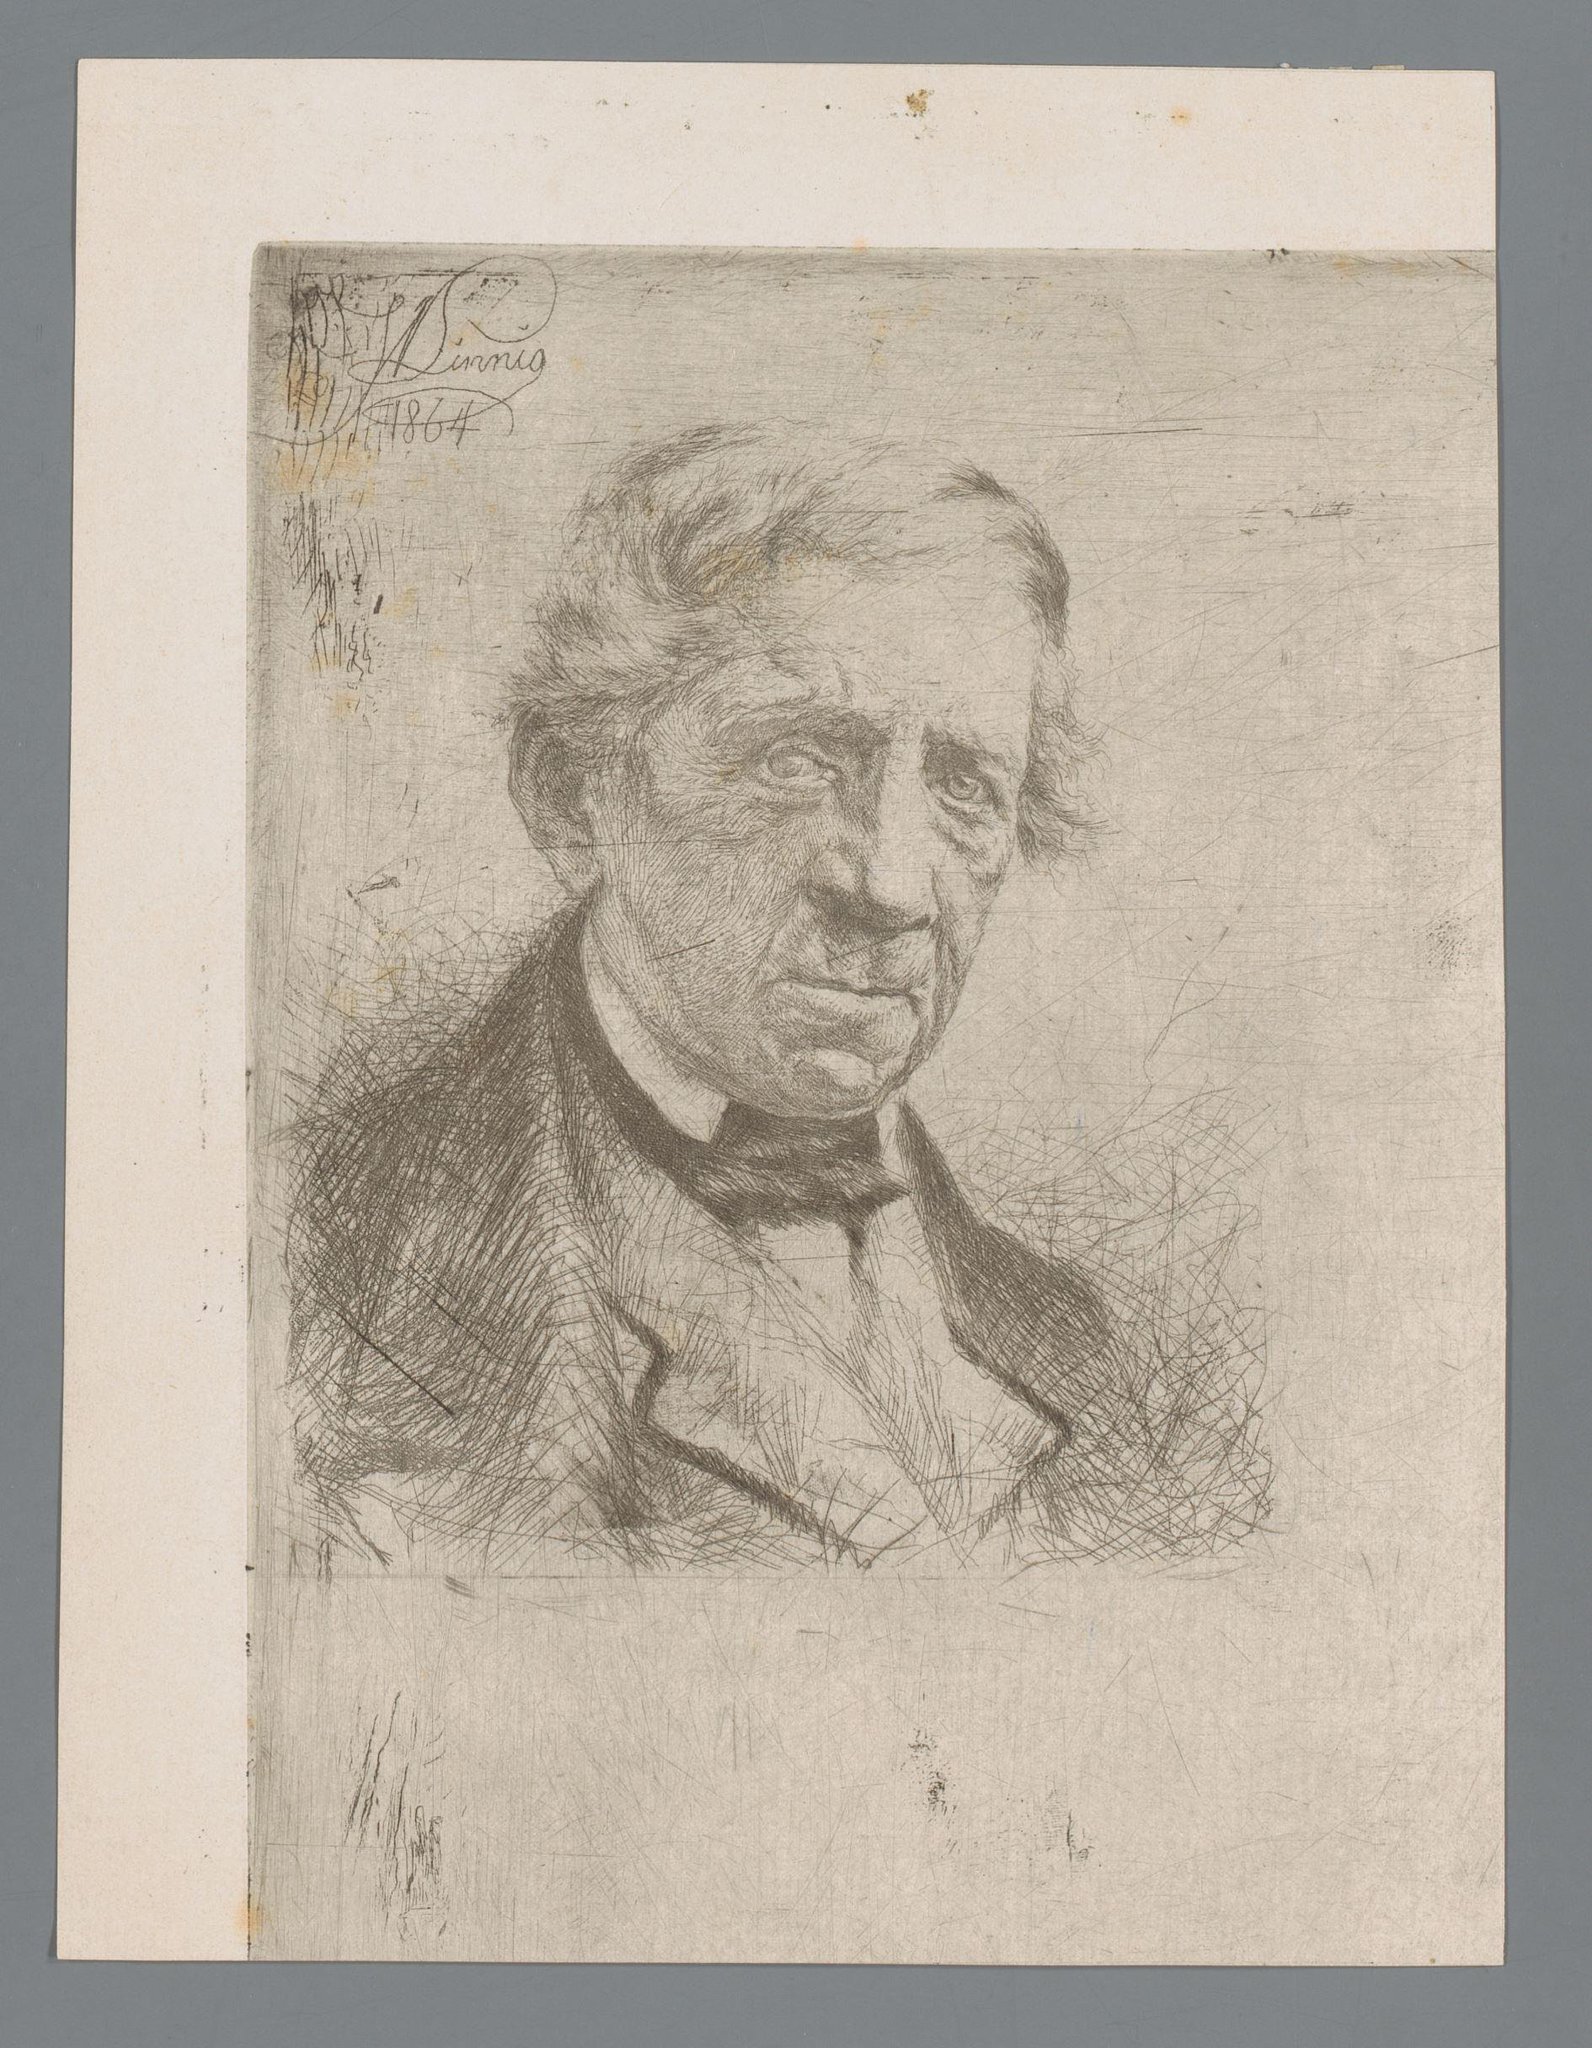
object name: print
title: Portret van een onbekende man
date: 1864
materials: paper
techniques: drypoint, etching, intaglio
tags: anonymous historical person portrayed alone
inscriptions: collector's mark: Lugt 2228, collector's mark: Lugt 1485